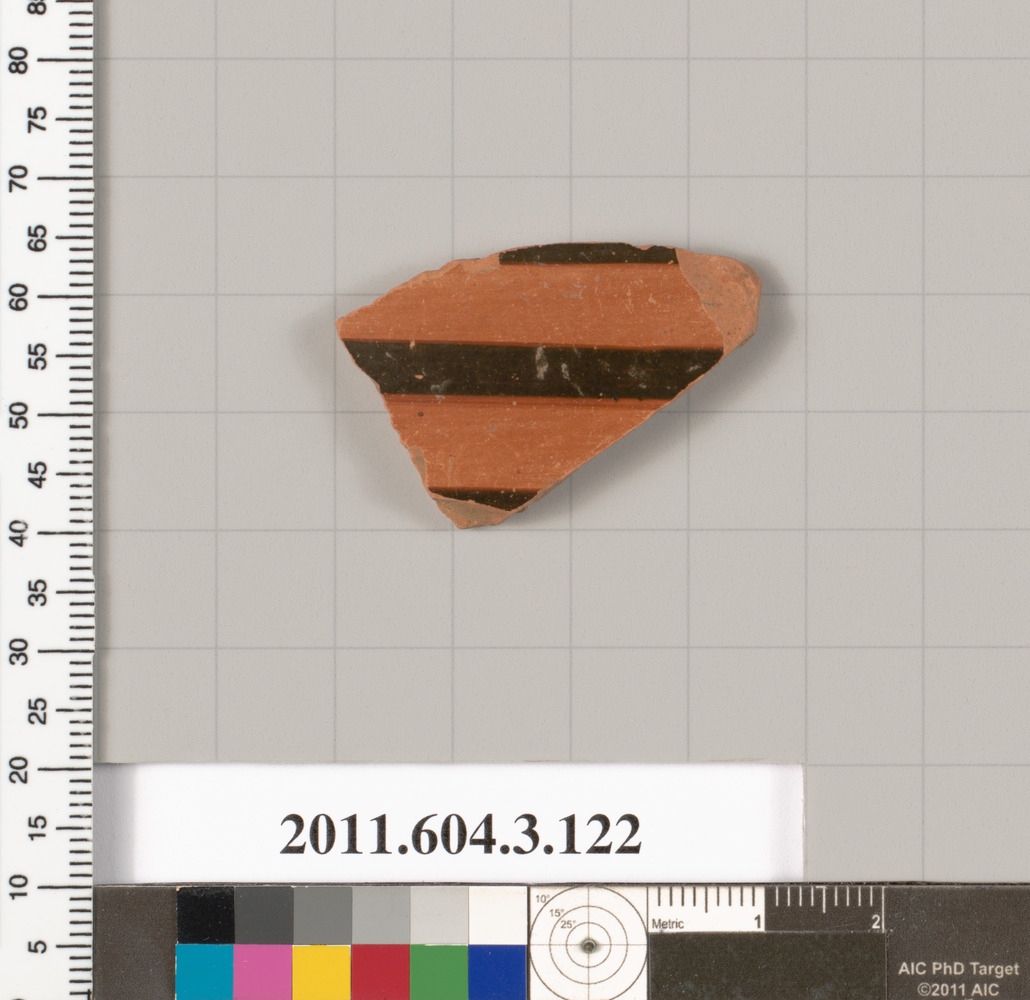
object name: amphora fragment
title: Terracotta fragment of an amphora (jar)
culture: greek, attic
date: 534-501 BCE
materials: terracotta